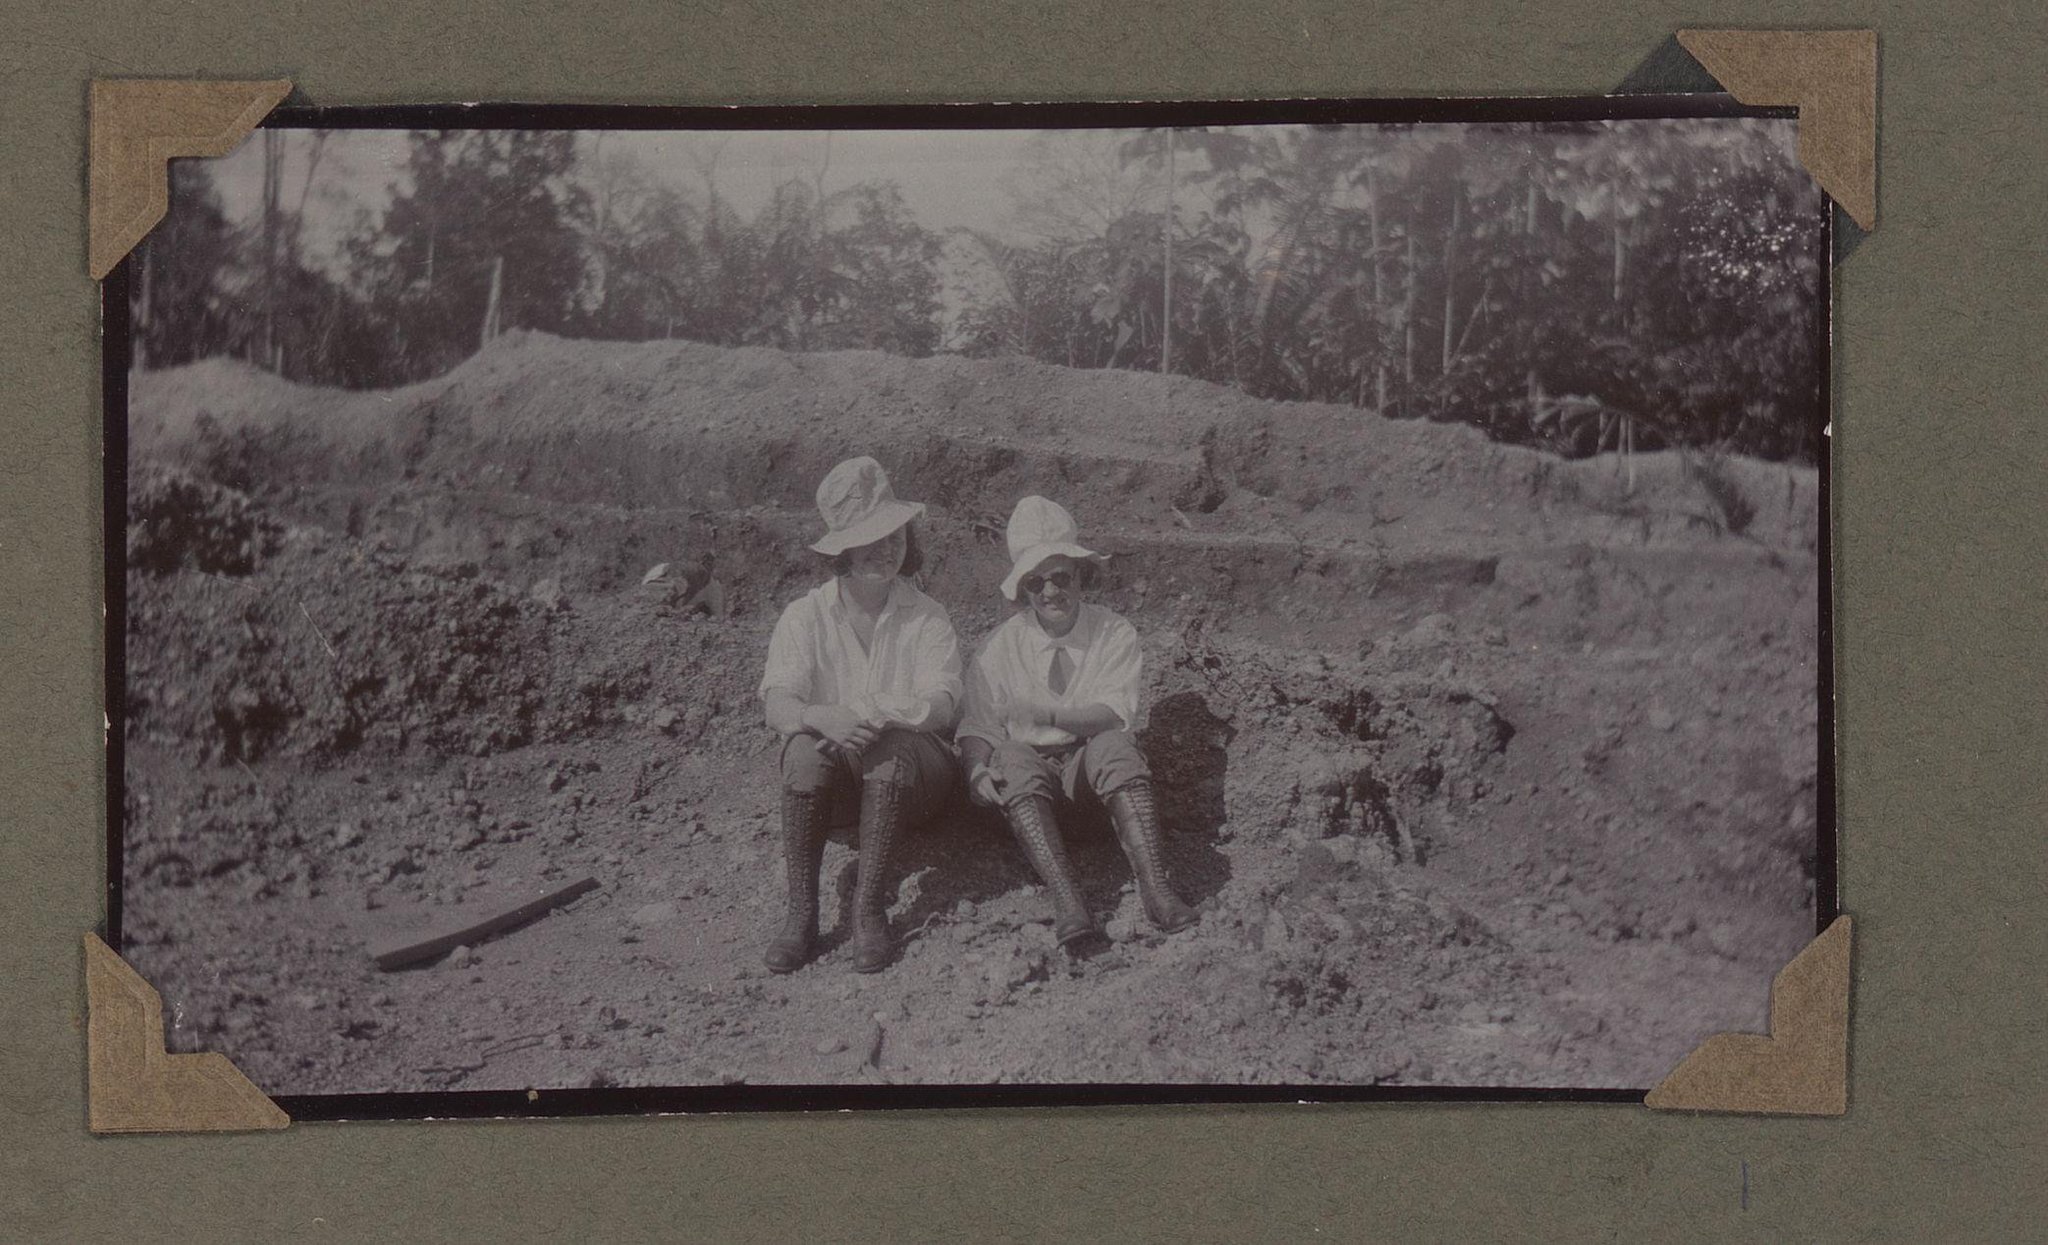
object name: photograph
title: Edith Jetten met een vrouw zittend op de grond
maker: Anonymous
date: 1925-1927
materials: photographic support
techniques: photography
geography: suriname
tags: jetten, familie, moengo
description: Edith Jetten met een vrouw zittend op de grond. Foto op een bladzijde van een los albumblad. Onderdeel van het ensemble met foto's van de familie van ingenieur Jetten in de mijnbouwstad Moengo in Suriname.